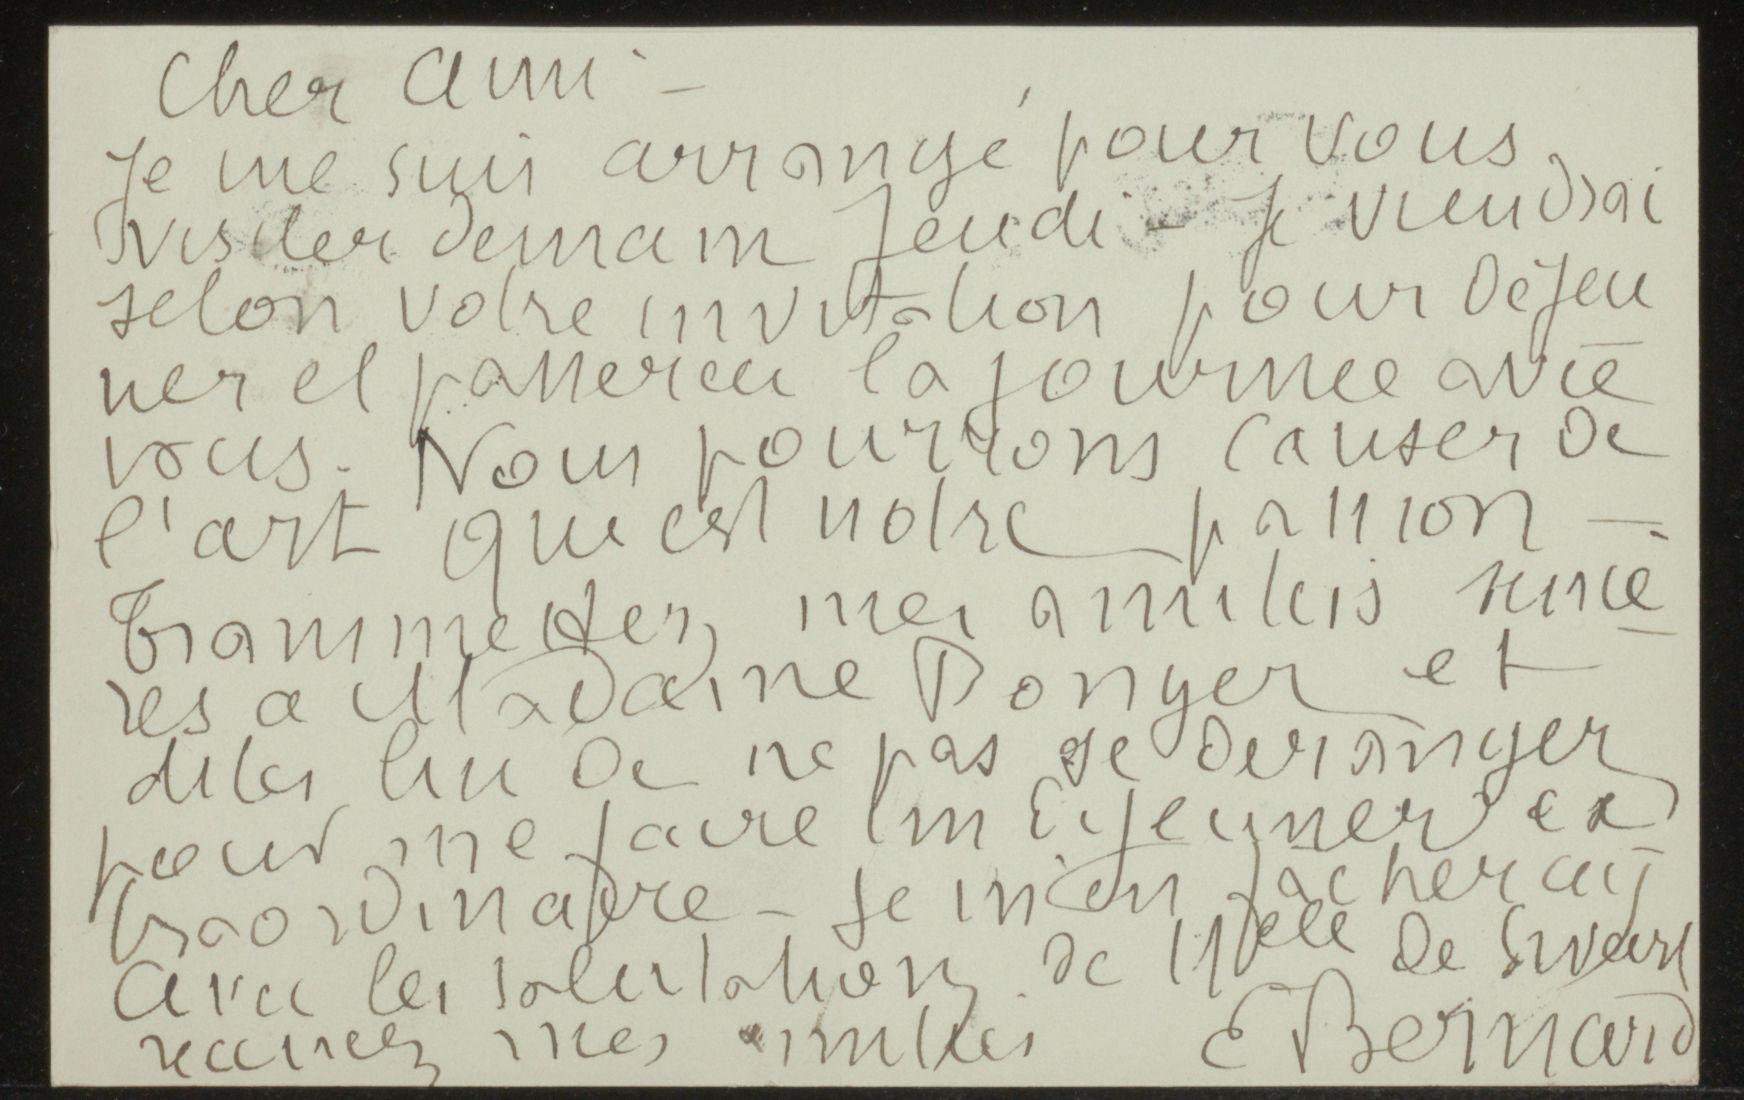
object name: postcard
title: Briefkaart aan Andries Bonger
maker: émile bernard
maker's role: print maker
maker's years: 1868-1941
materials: cardboard, ink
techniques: pen, writing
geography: laren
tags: amsterdam, andries bonger